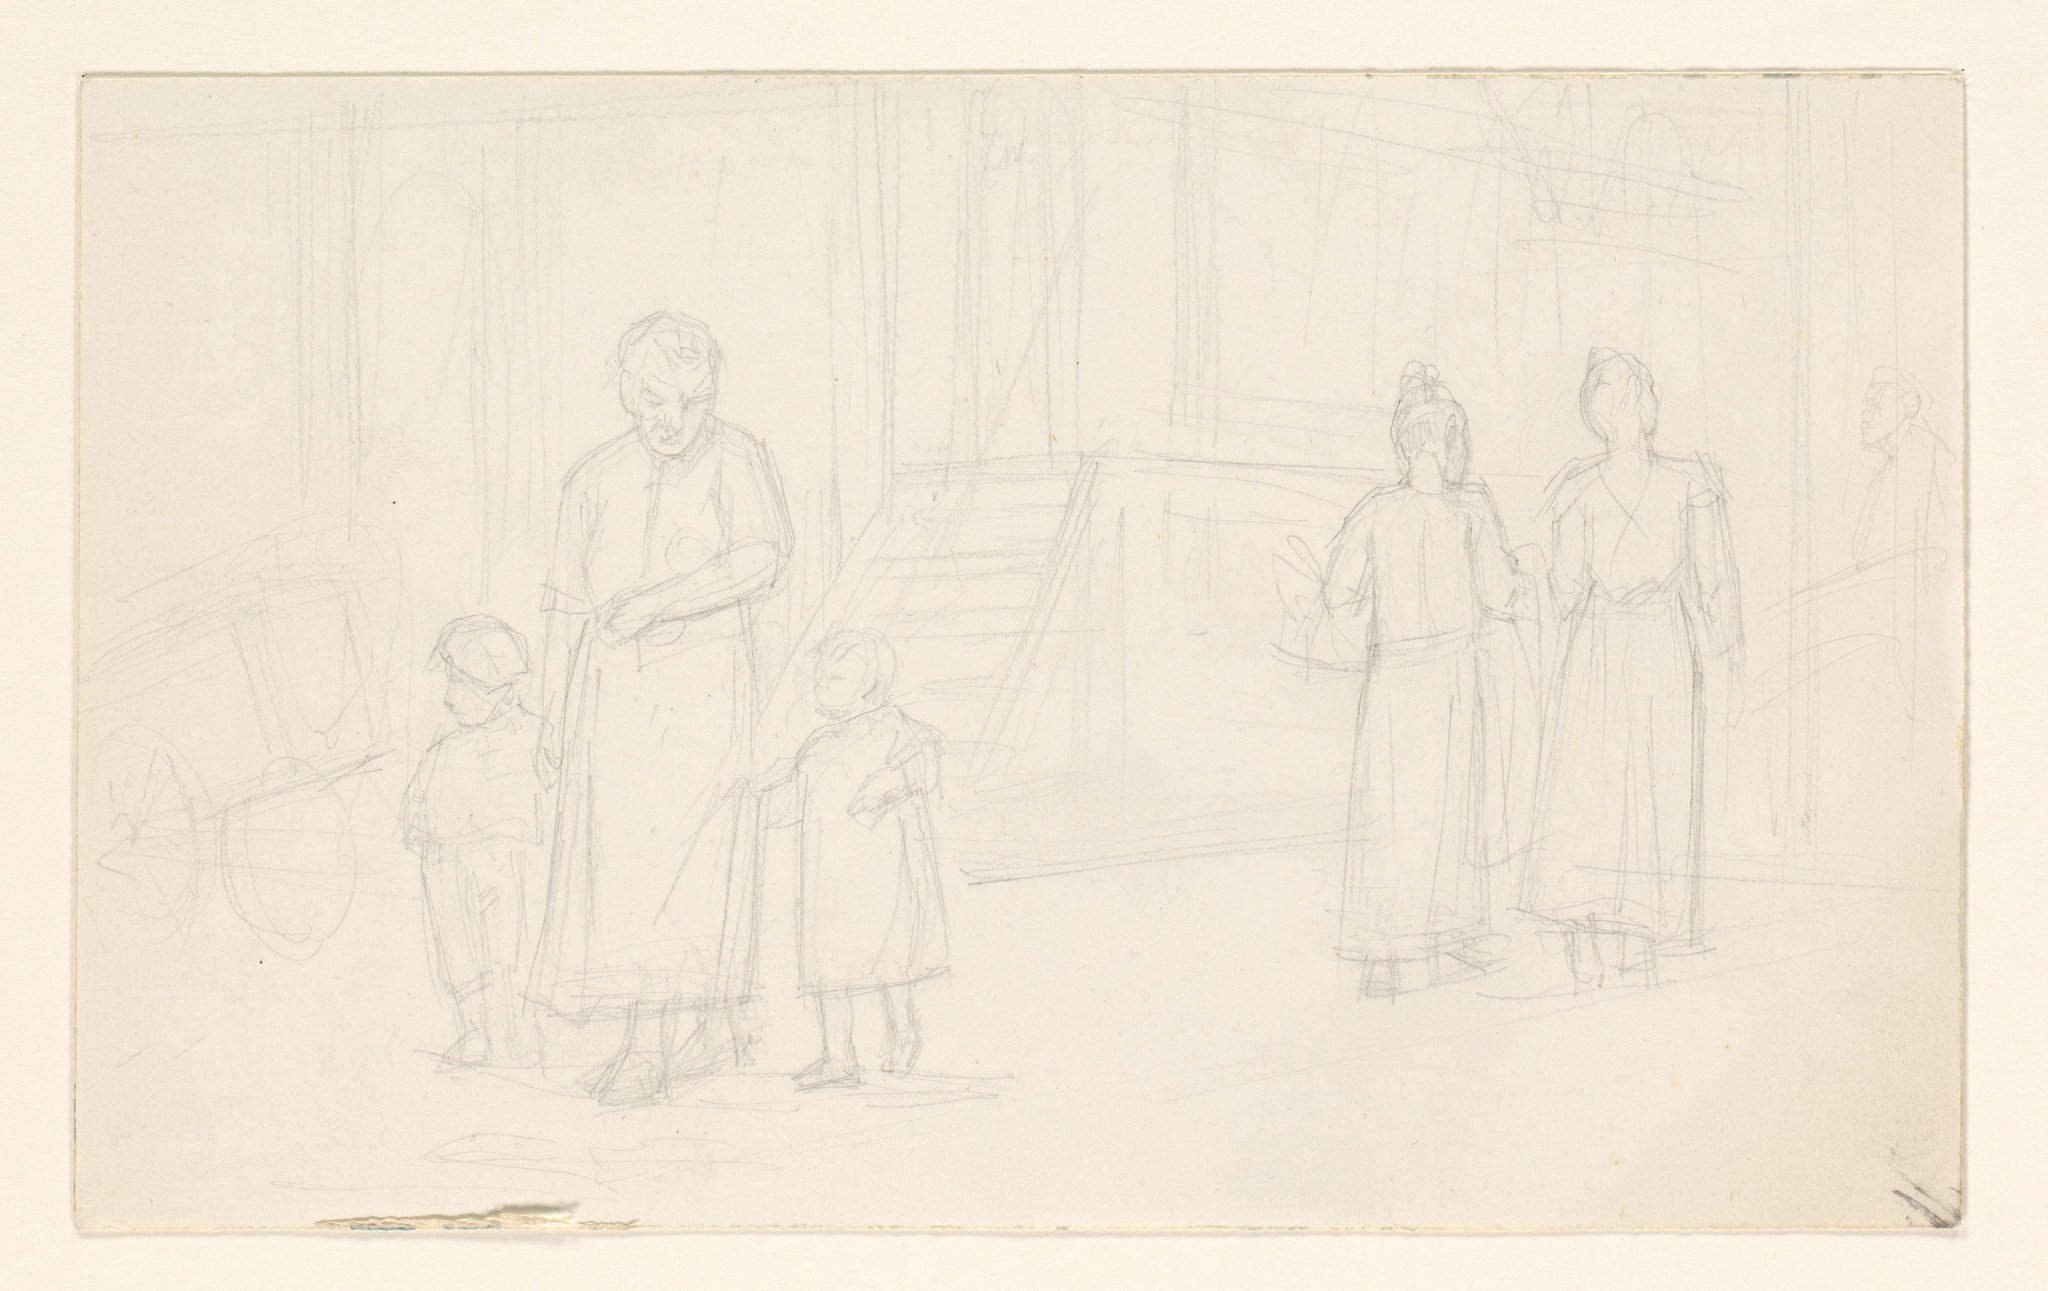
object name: drawing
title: Gezicht op een straat met vrouwen en kinderen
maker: august allebé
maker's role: draughtsman, print maker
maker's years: 1838-1927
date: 1848-1927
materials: paper, pencil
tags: street